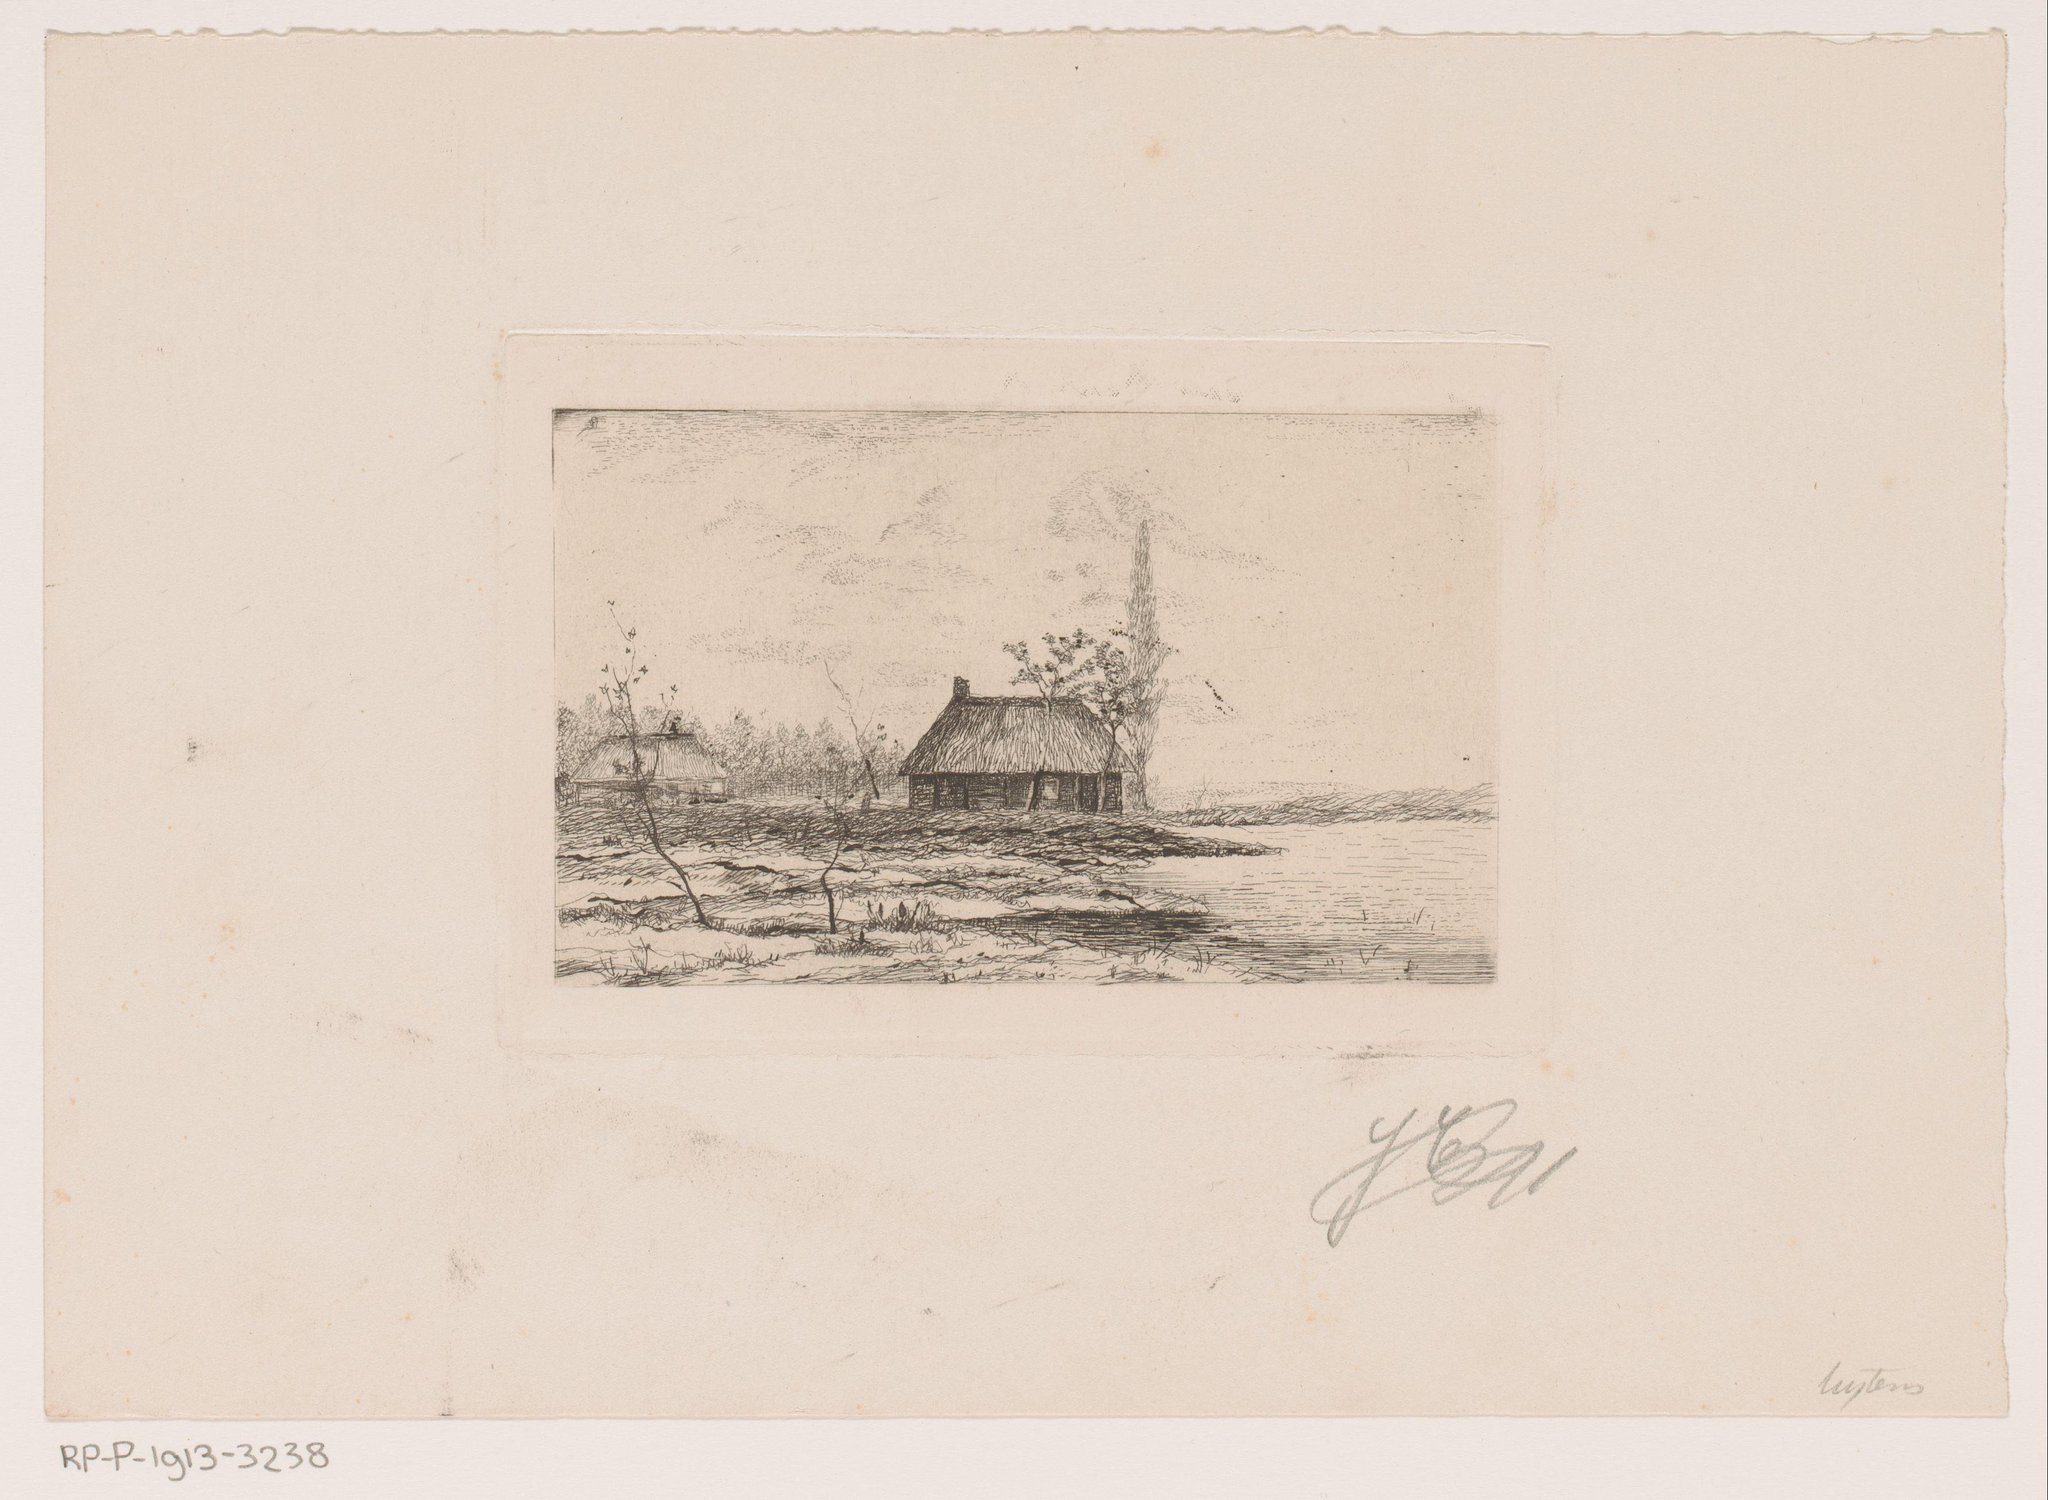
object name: print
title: Landschap met twee boerderijen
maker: jerôme tuyttens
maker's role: painter, print maker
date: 1850-1900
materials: paper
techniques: drypoint, etching, intaglio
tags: farm or solitary house in landscape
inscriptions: collector's mark: Lugt 2228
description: Sterfdatum van de prentmaker is onbekend. Daarom is voor de bepaling van de rechten van dit object gebruik gemaakt van de verwervingsdatum Rijksmuseum Amsterdam.